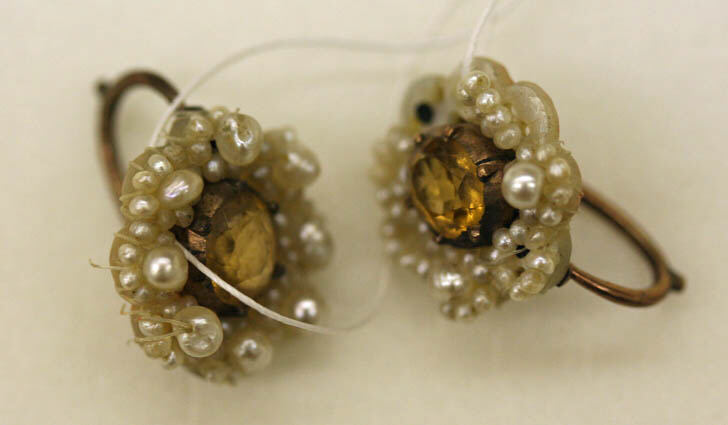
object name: earring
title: Earrings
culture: american or european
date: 1801-1900